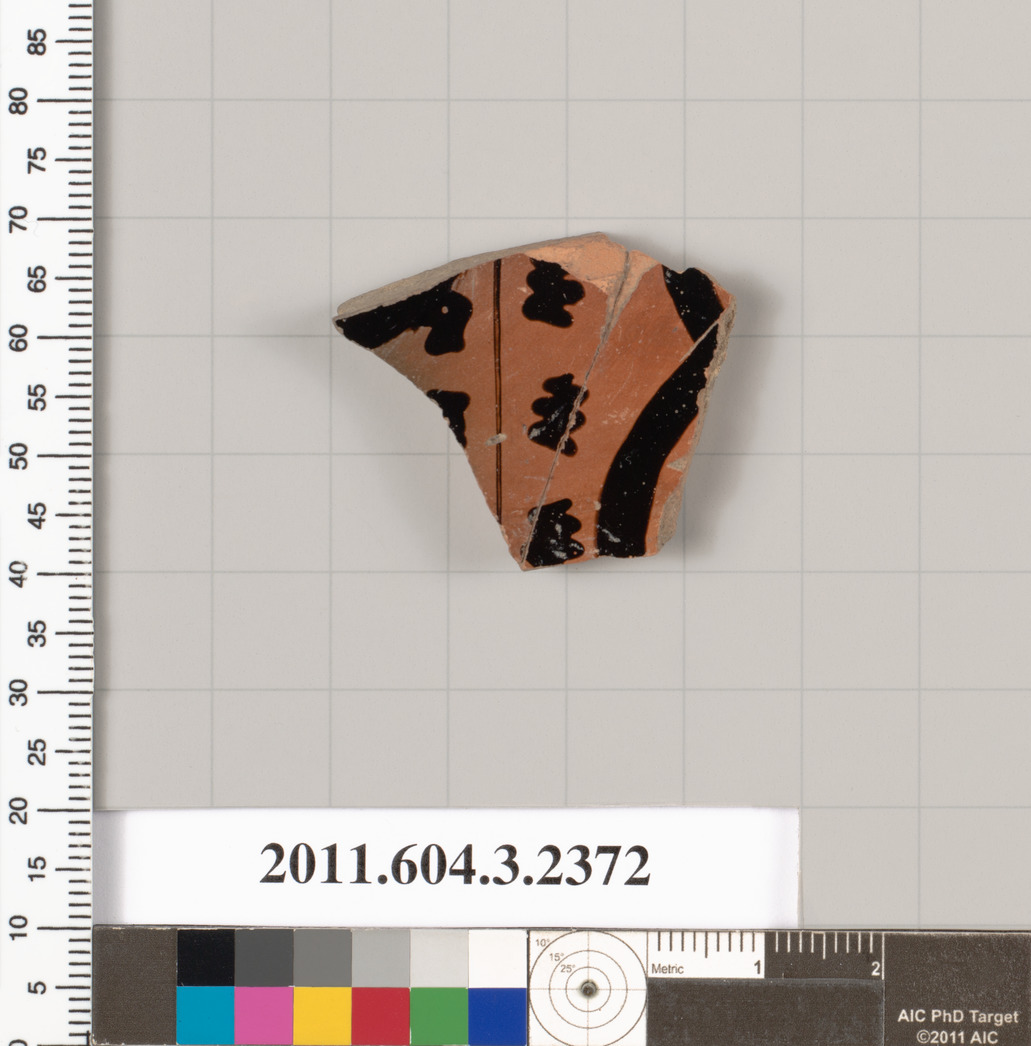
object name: kylix fragment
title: Terracotta fragment of a kylix: eye-cup (drinking cup)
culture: greek, attic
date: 540-520 BCE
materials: terracotta